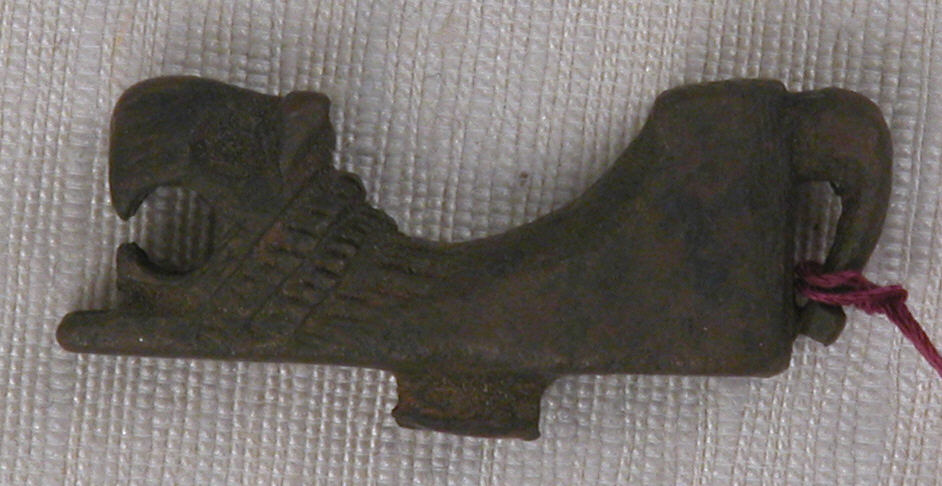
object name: finial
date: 700-1200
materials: bronze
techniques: casting, engraving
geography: iran